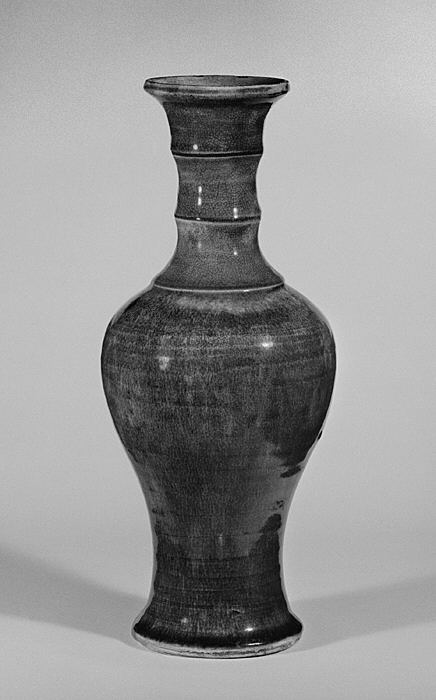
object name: vase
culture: chinese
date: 1501-1600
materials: glaze, stoneware